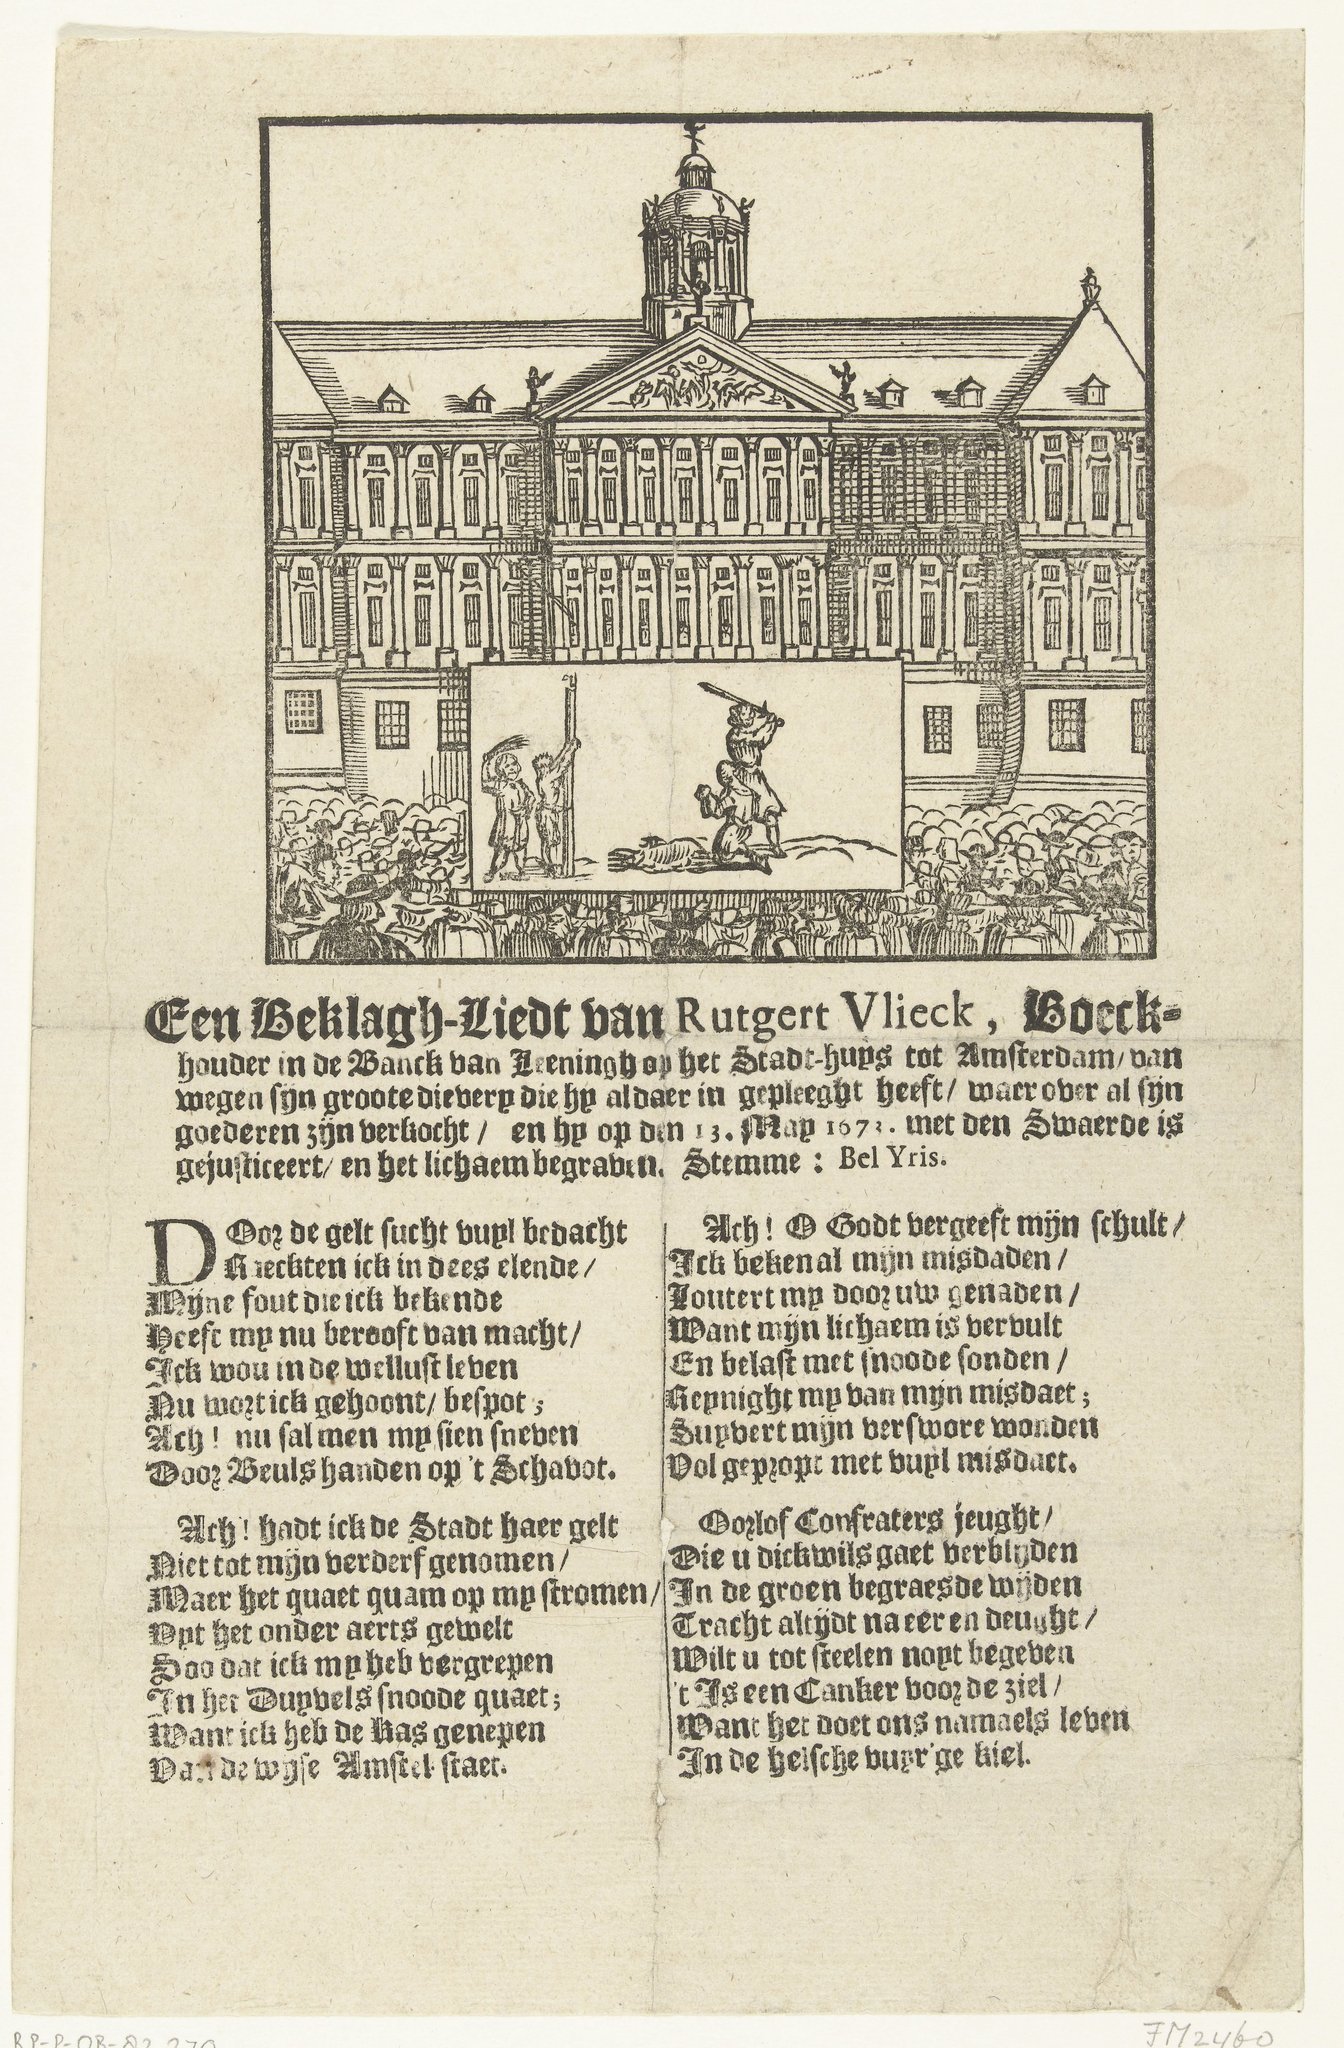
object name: print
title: Een Beklagh-Liedt van Rutgert Vlieck, Boeck-houder in de Banck van Leeningh (...)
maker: Anonymous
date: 1673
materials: paper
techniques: letterpress printing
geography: northern netherlands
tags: on the scaffold or place of execution, violent death by beheading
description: Klaaglied van Rutgert Vlieck, een boekhouder werkzaam in de bank van lening op het stadhuis te Amsterdam, veroordeeld wegens diefstal tot onthoofding. Voorstelling van de geseling en onthoofding op een schavot voor het stadhuis van Amsterdam, 13 mei 1673, met onderschrift van 4 verzen.